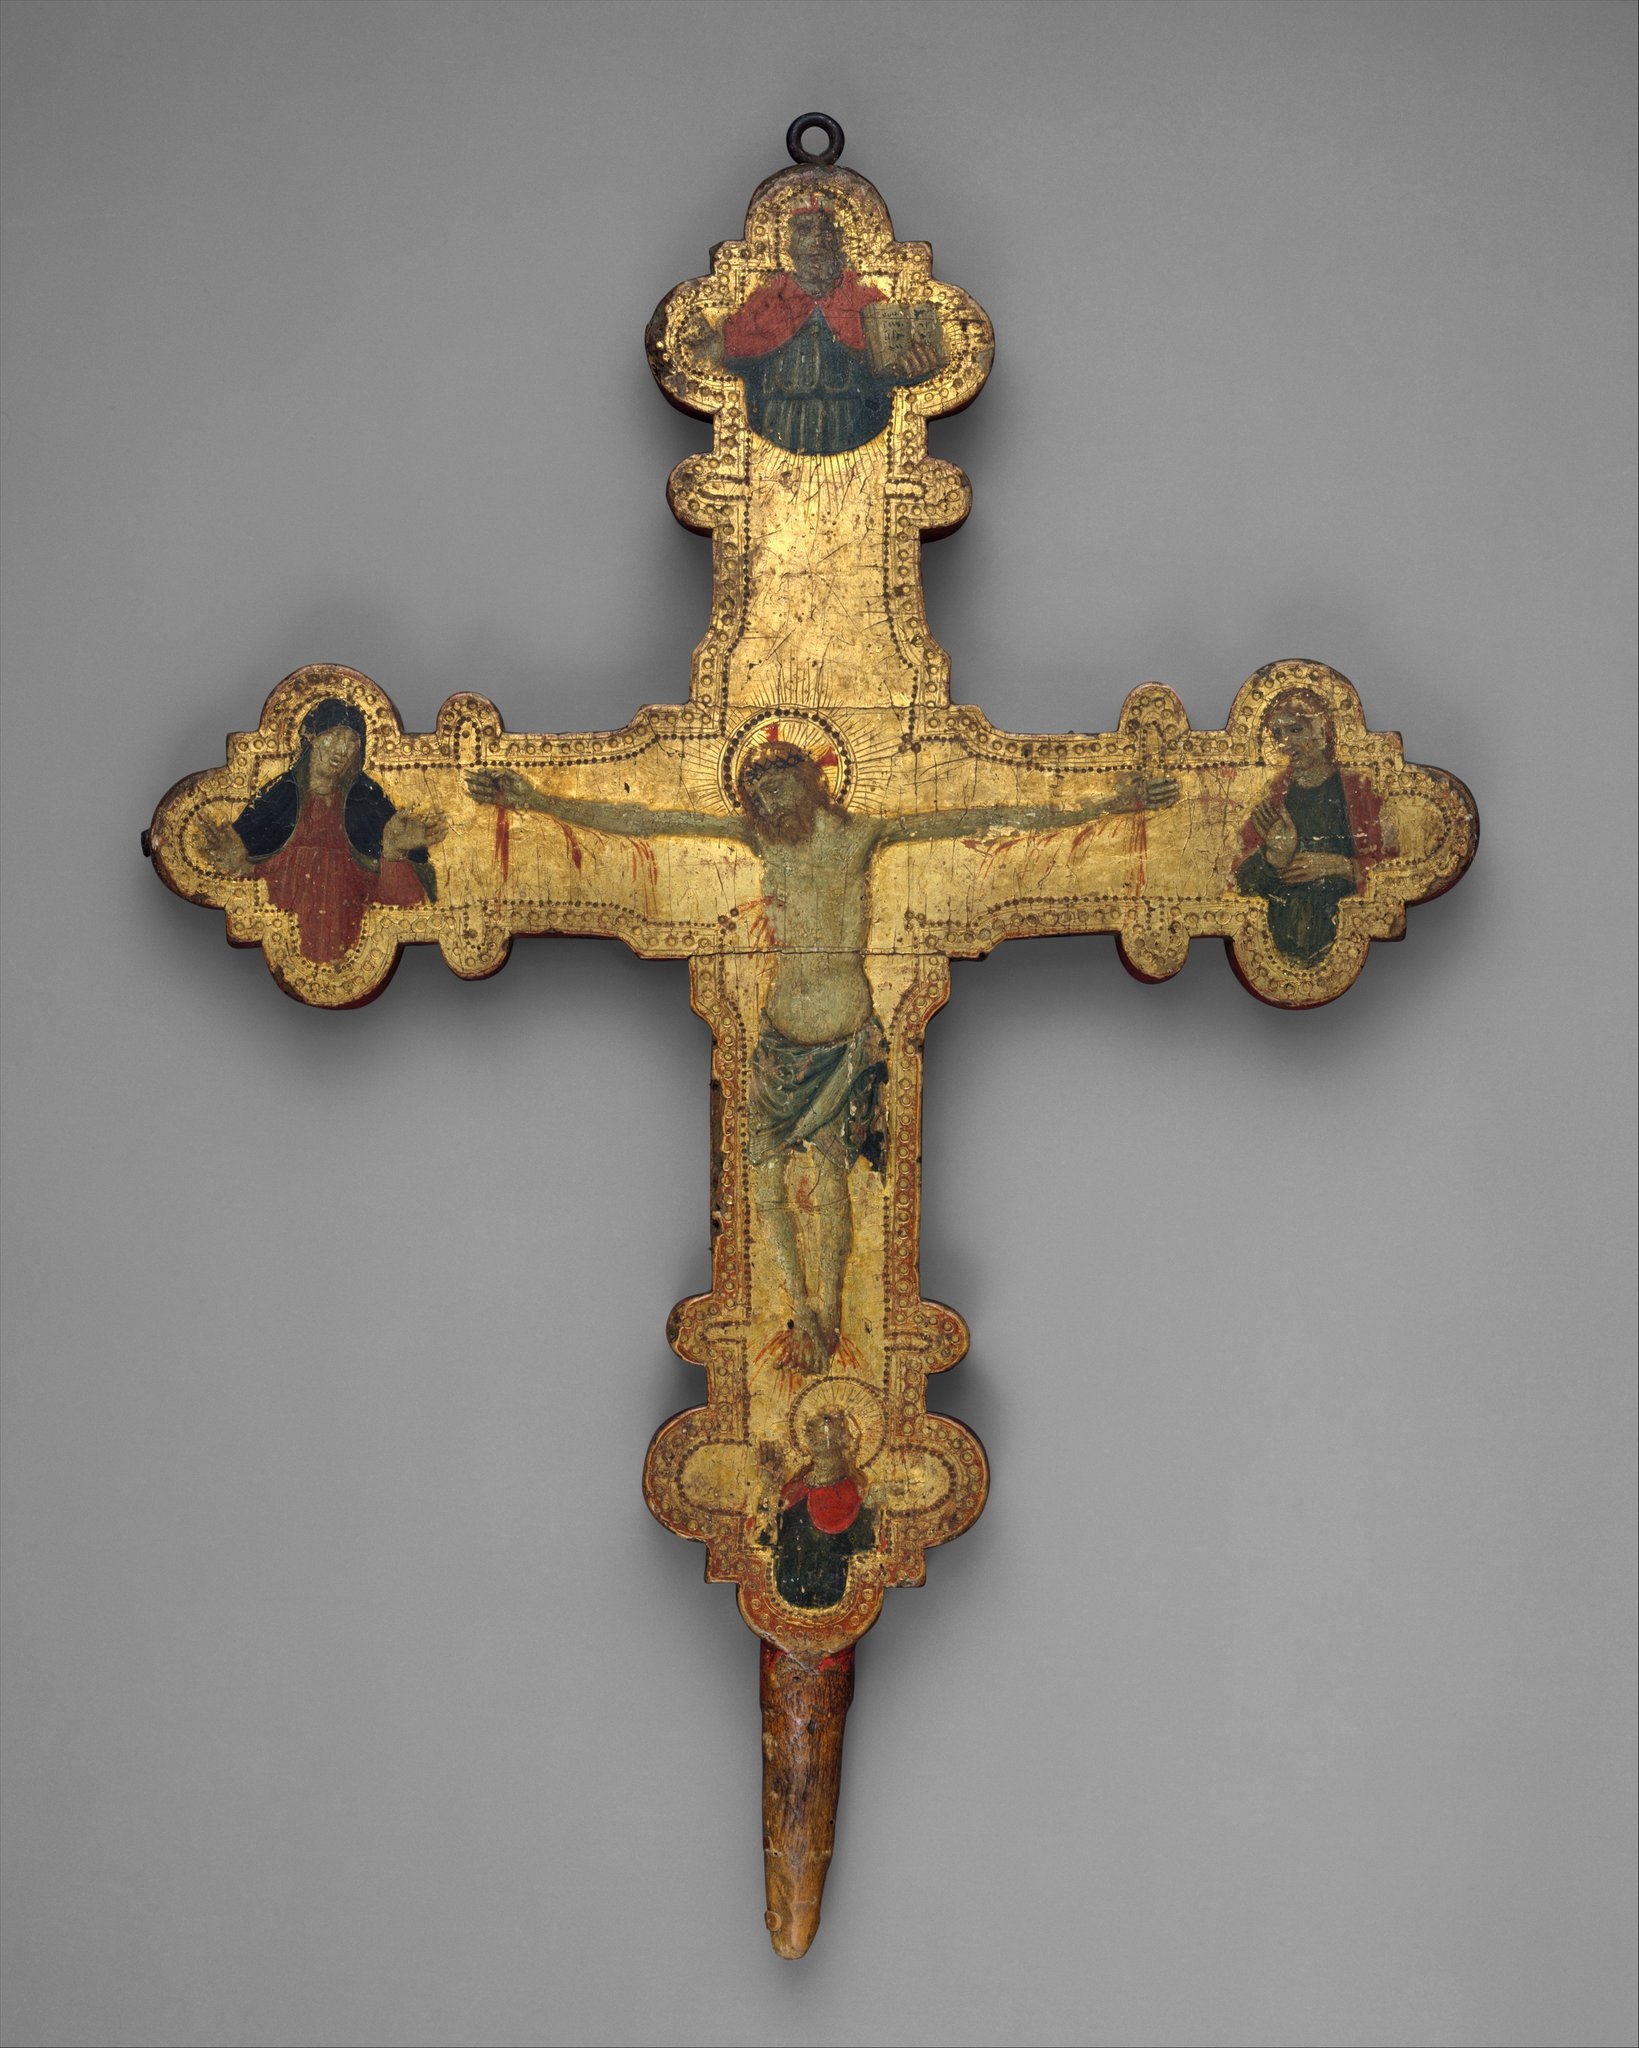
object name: painting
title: Crucifix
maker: attributed to giovanni antonio da pesaro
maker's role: artist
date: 1450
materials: gold leaf, paint, wood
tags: christ,crucifixion